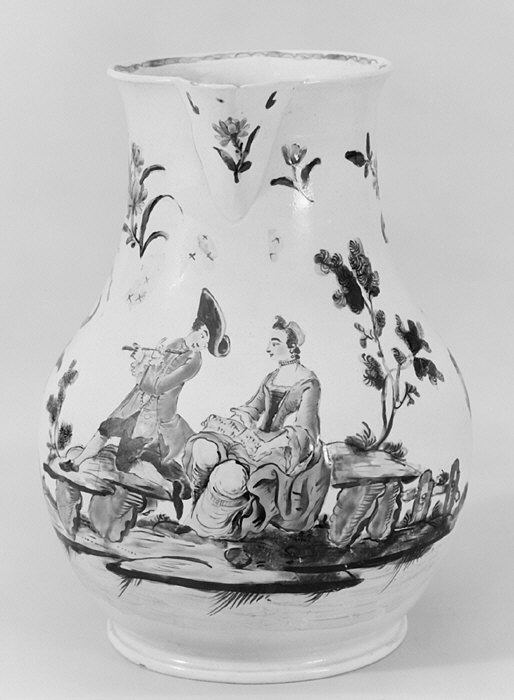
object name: jug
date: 1765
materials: stoneware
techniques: salt glaze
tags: men,women,flowers